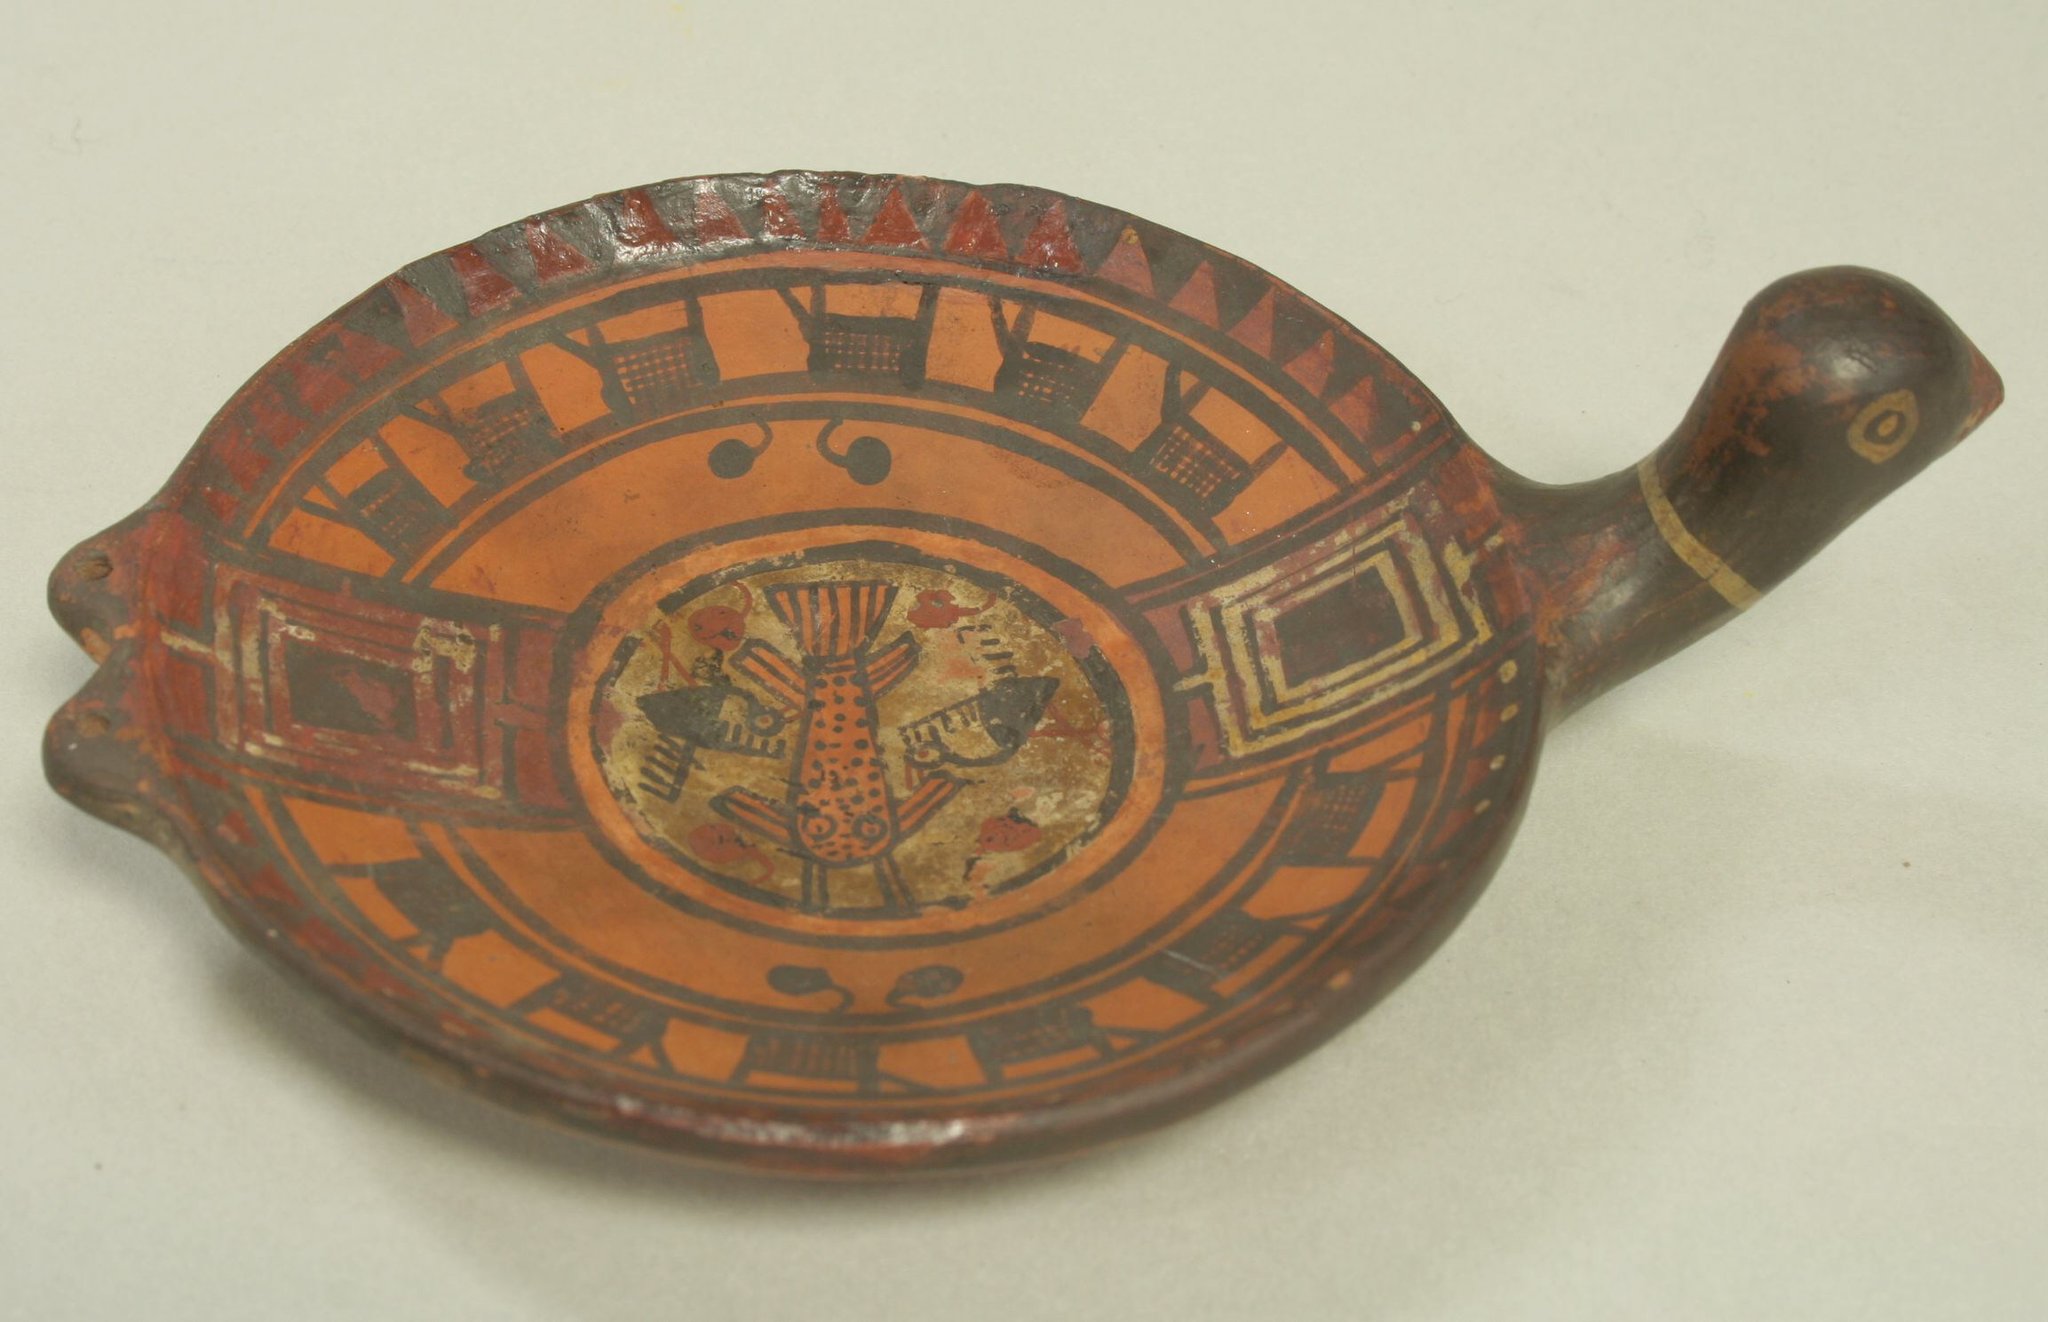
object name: dish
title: Dish with Bird Head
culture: inca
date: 1401-1600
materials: ceramic, pigment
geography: peru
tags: birds